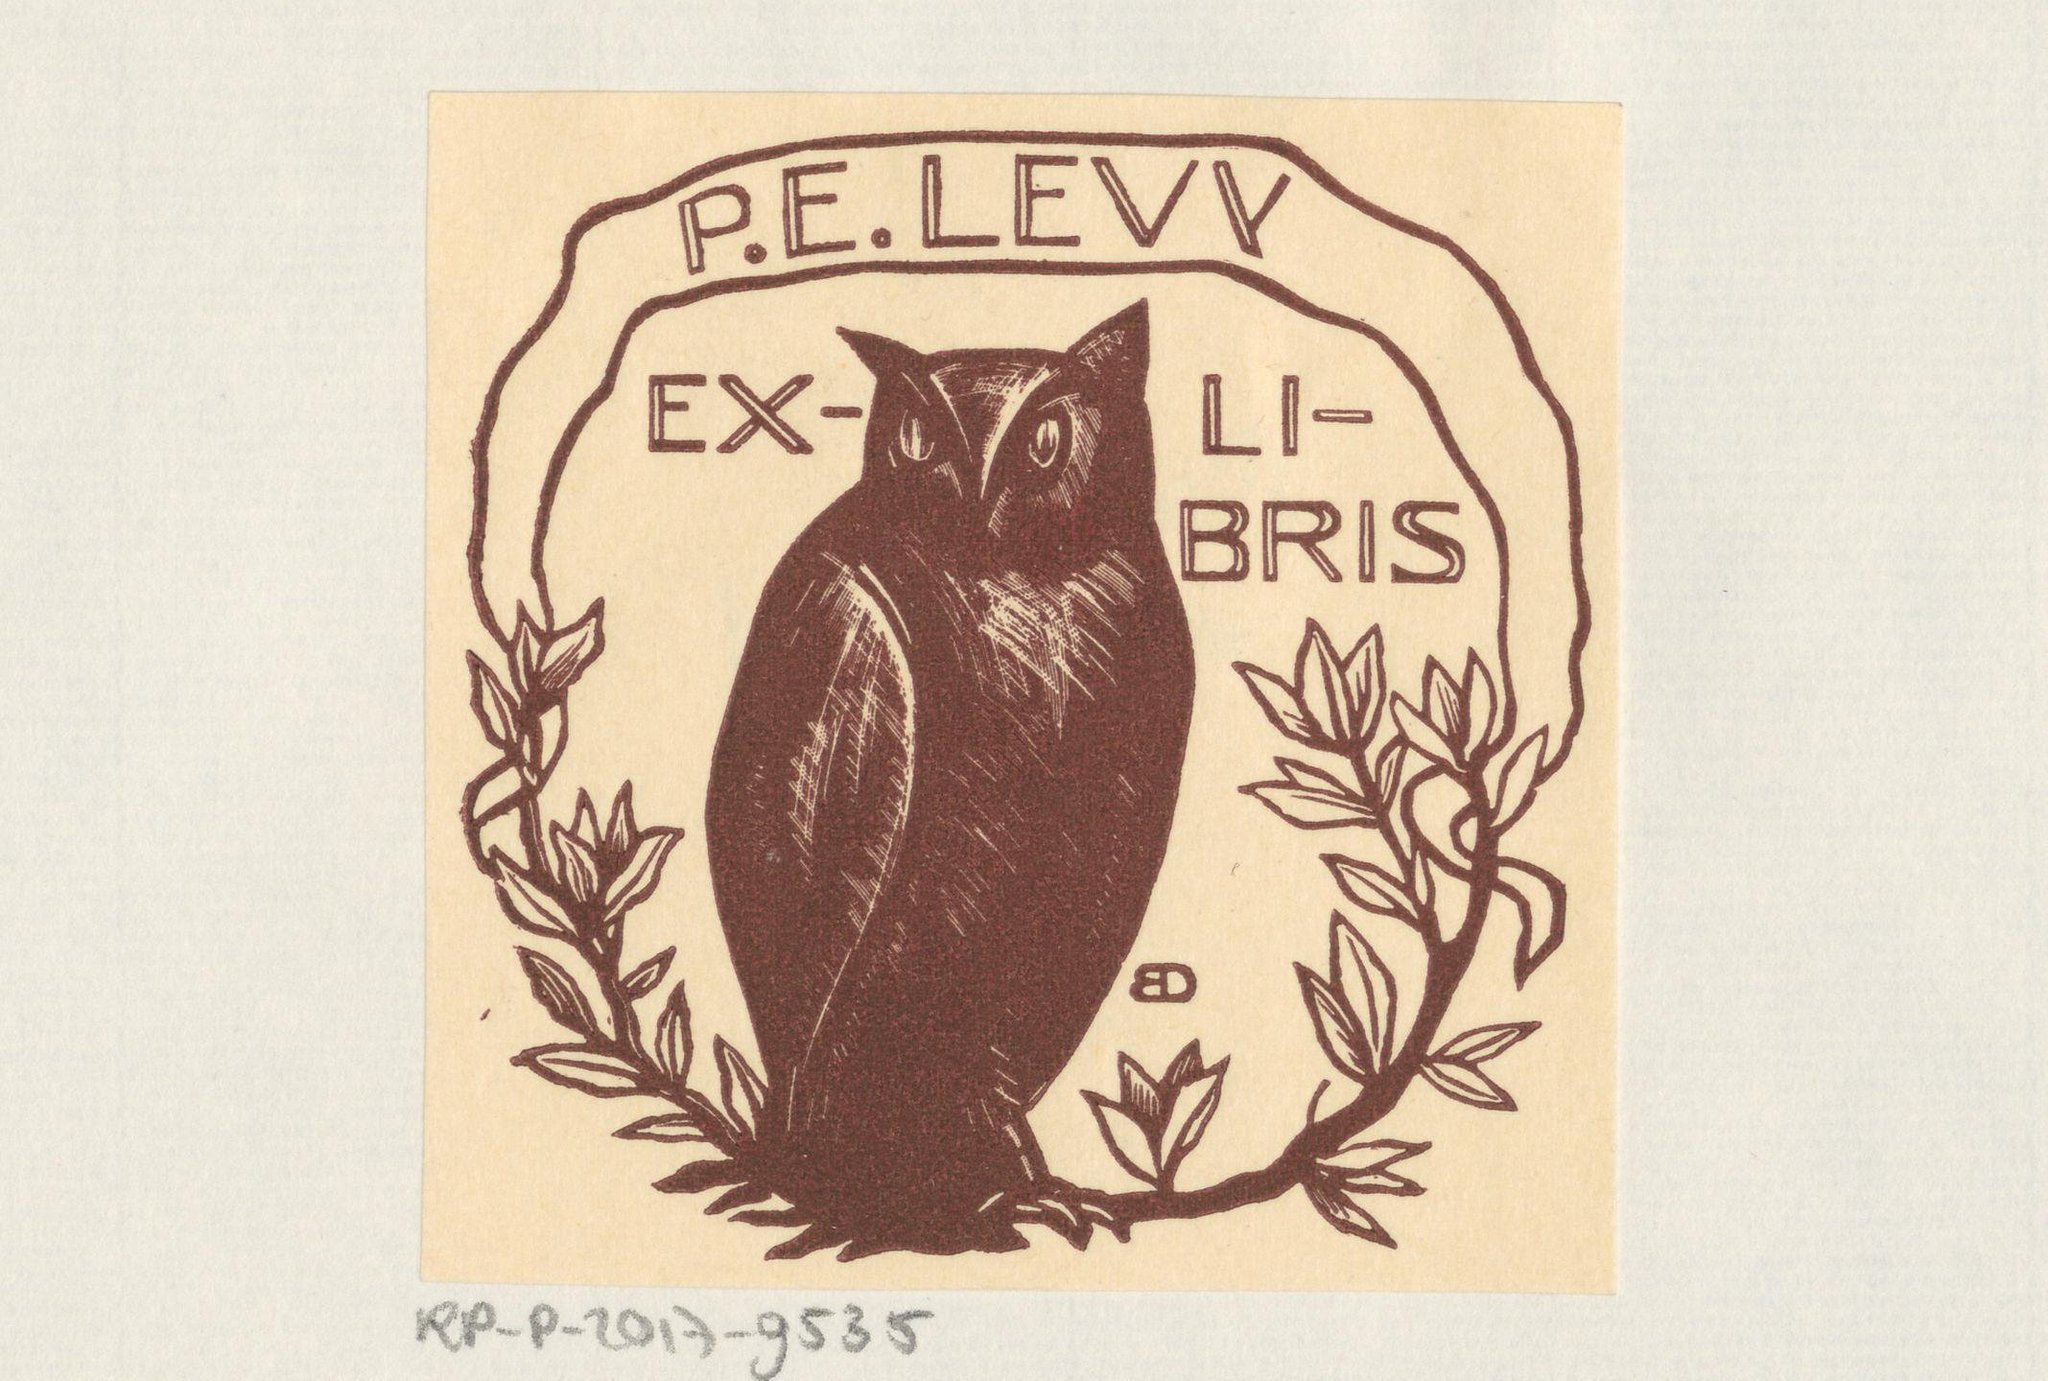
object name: bookplate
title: Ex libris van Pierre Edmond Lévy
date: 1920-1969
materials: paper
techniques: woodcut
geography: paris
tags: owls